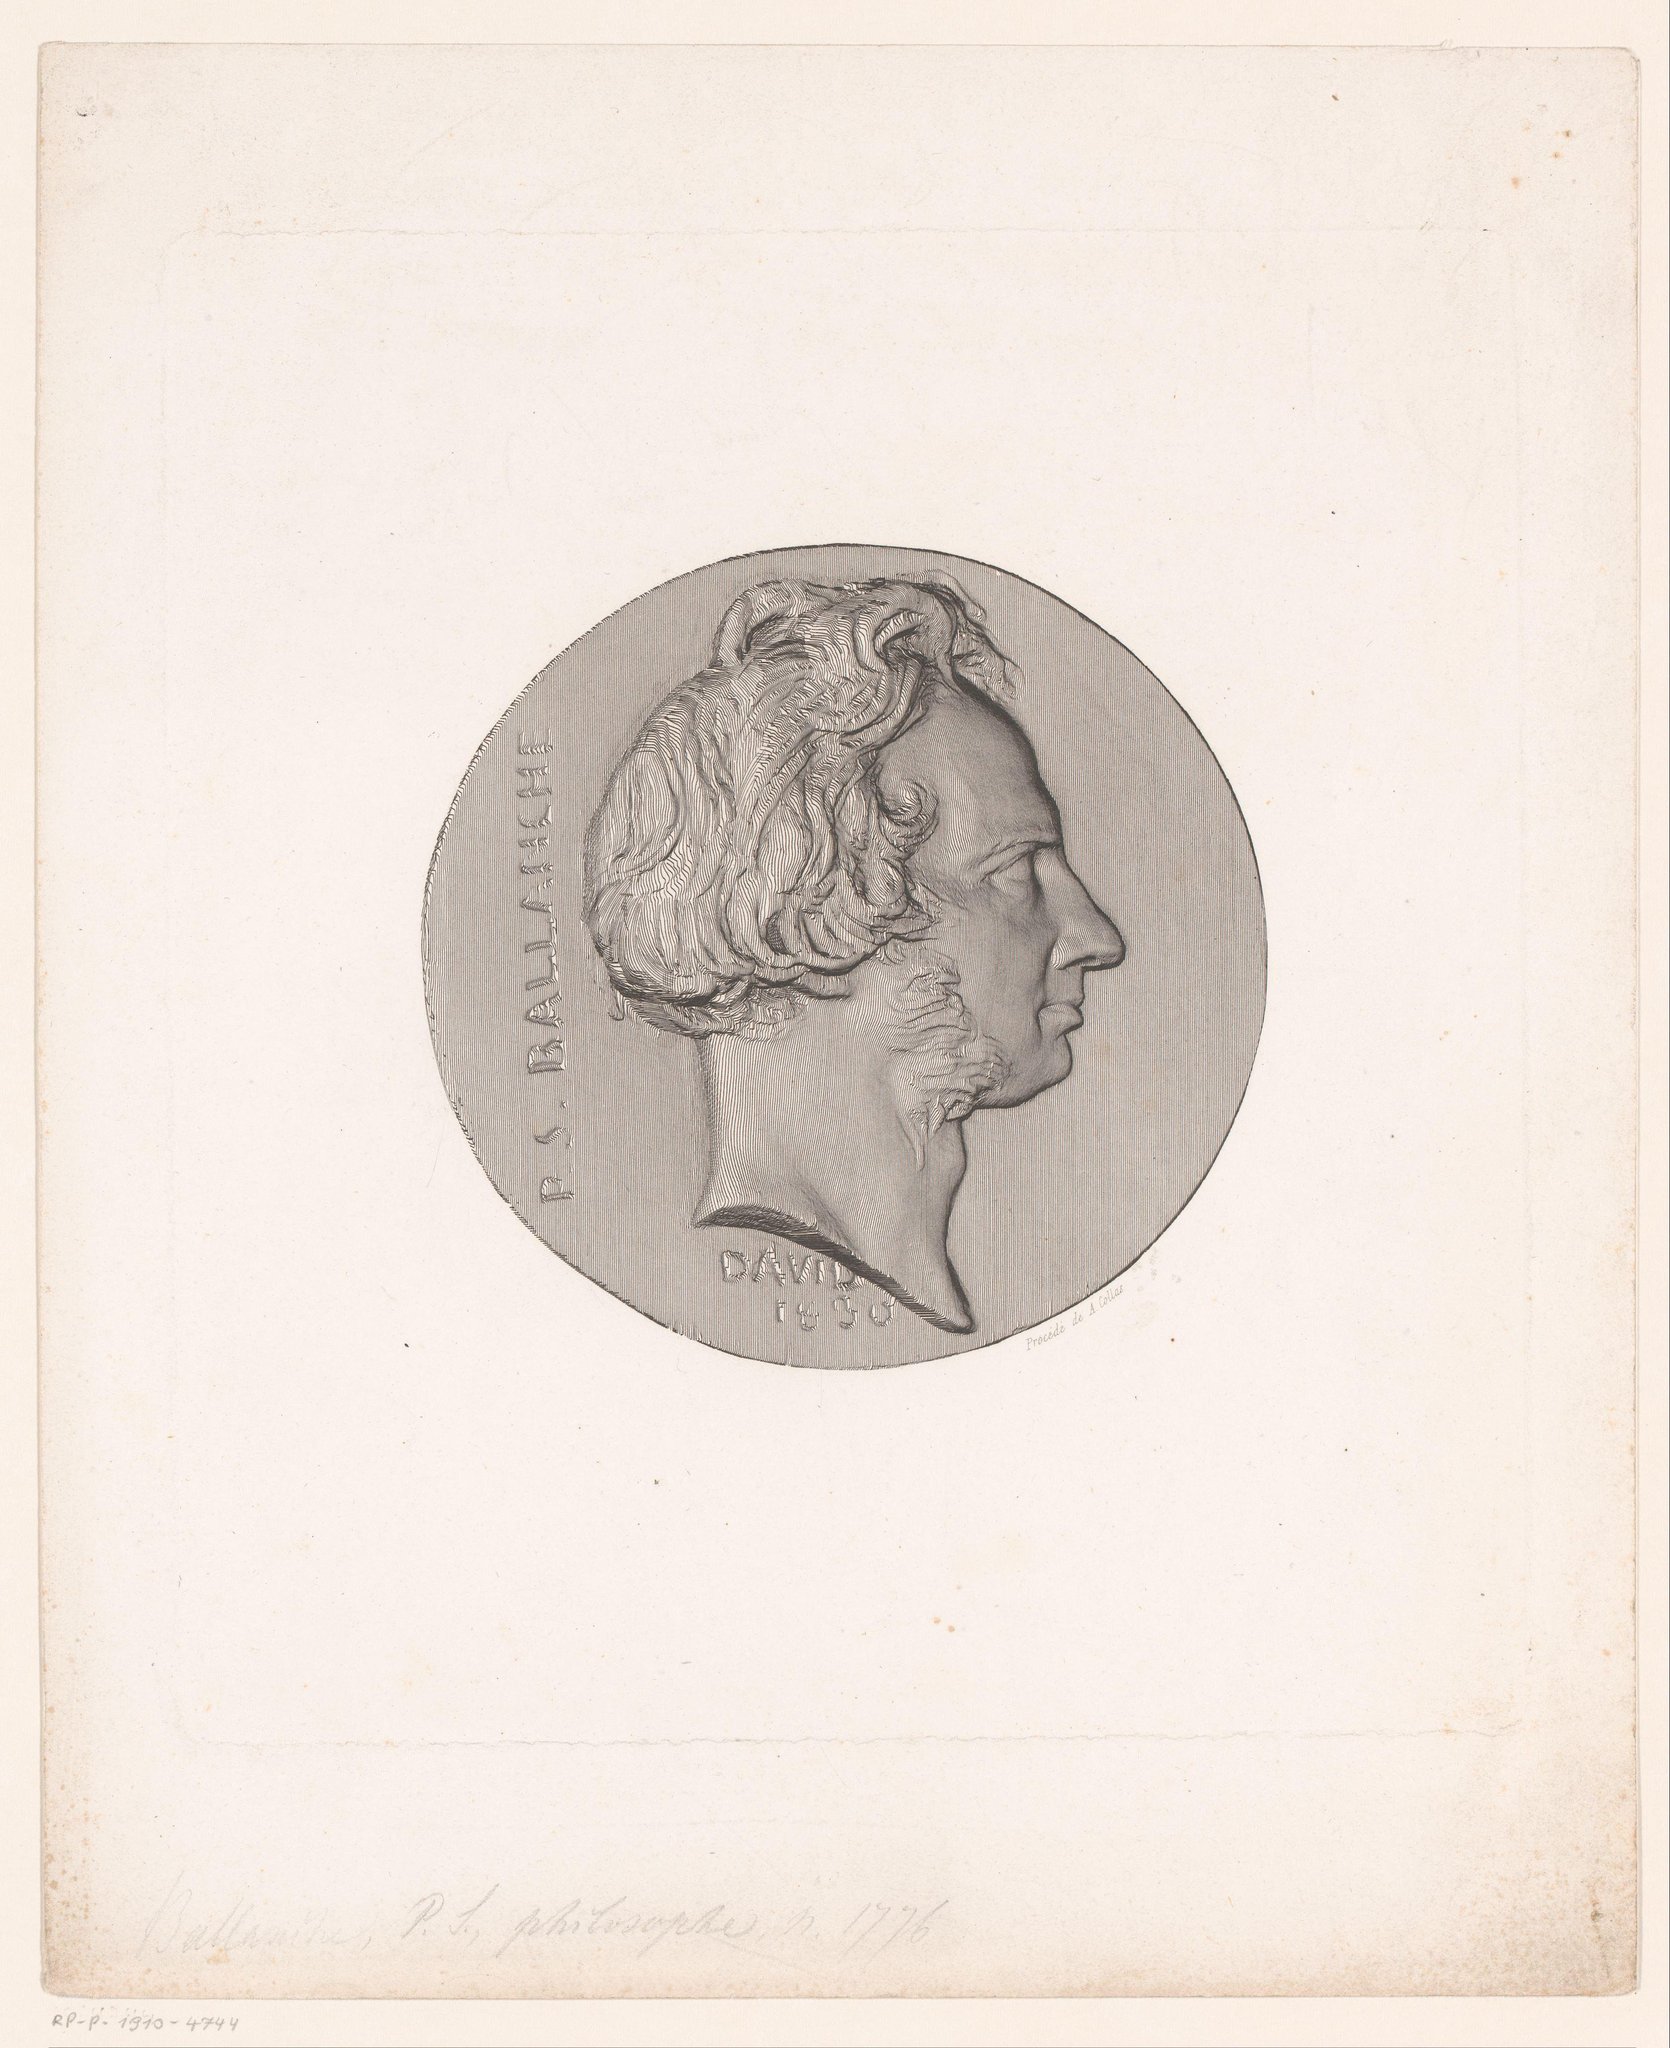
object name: print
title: P.S. Ballanche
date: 1830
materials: paper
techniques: relief engraving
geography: france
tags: lyon, paris, ornament ~ medallion, historical persons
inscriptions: collector's mark: Lugt 2228